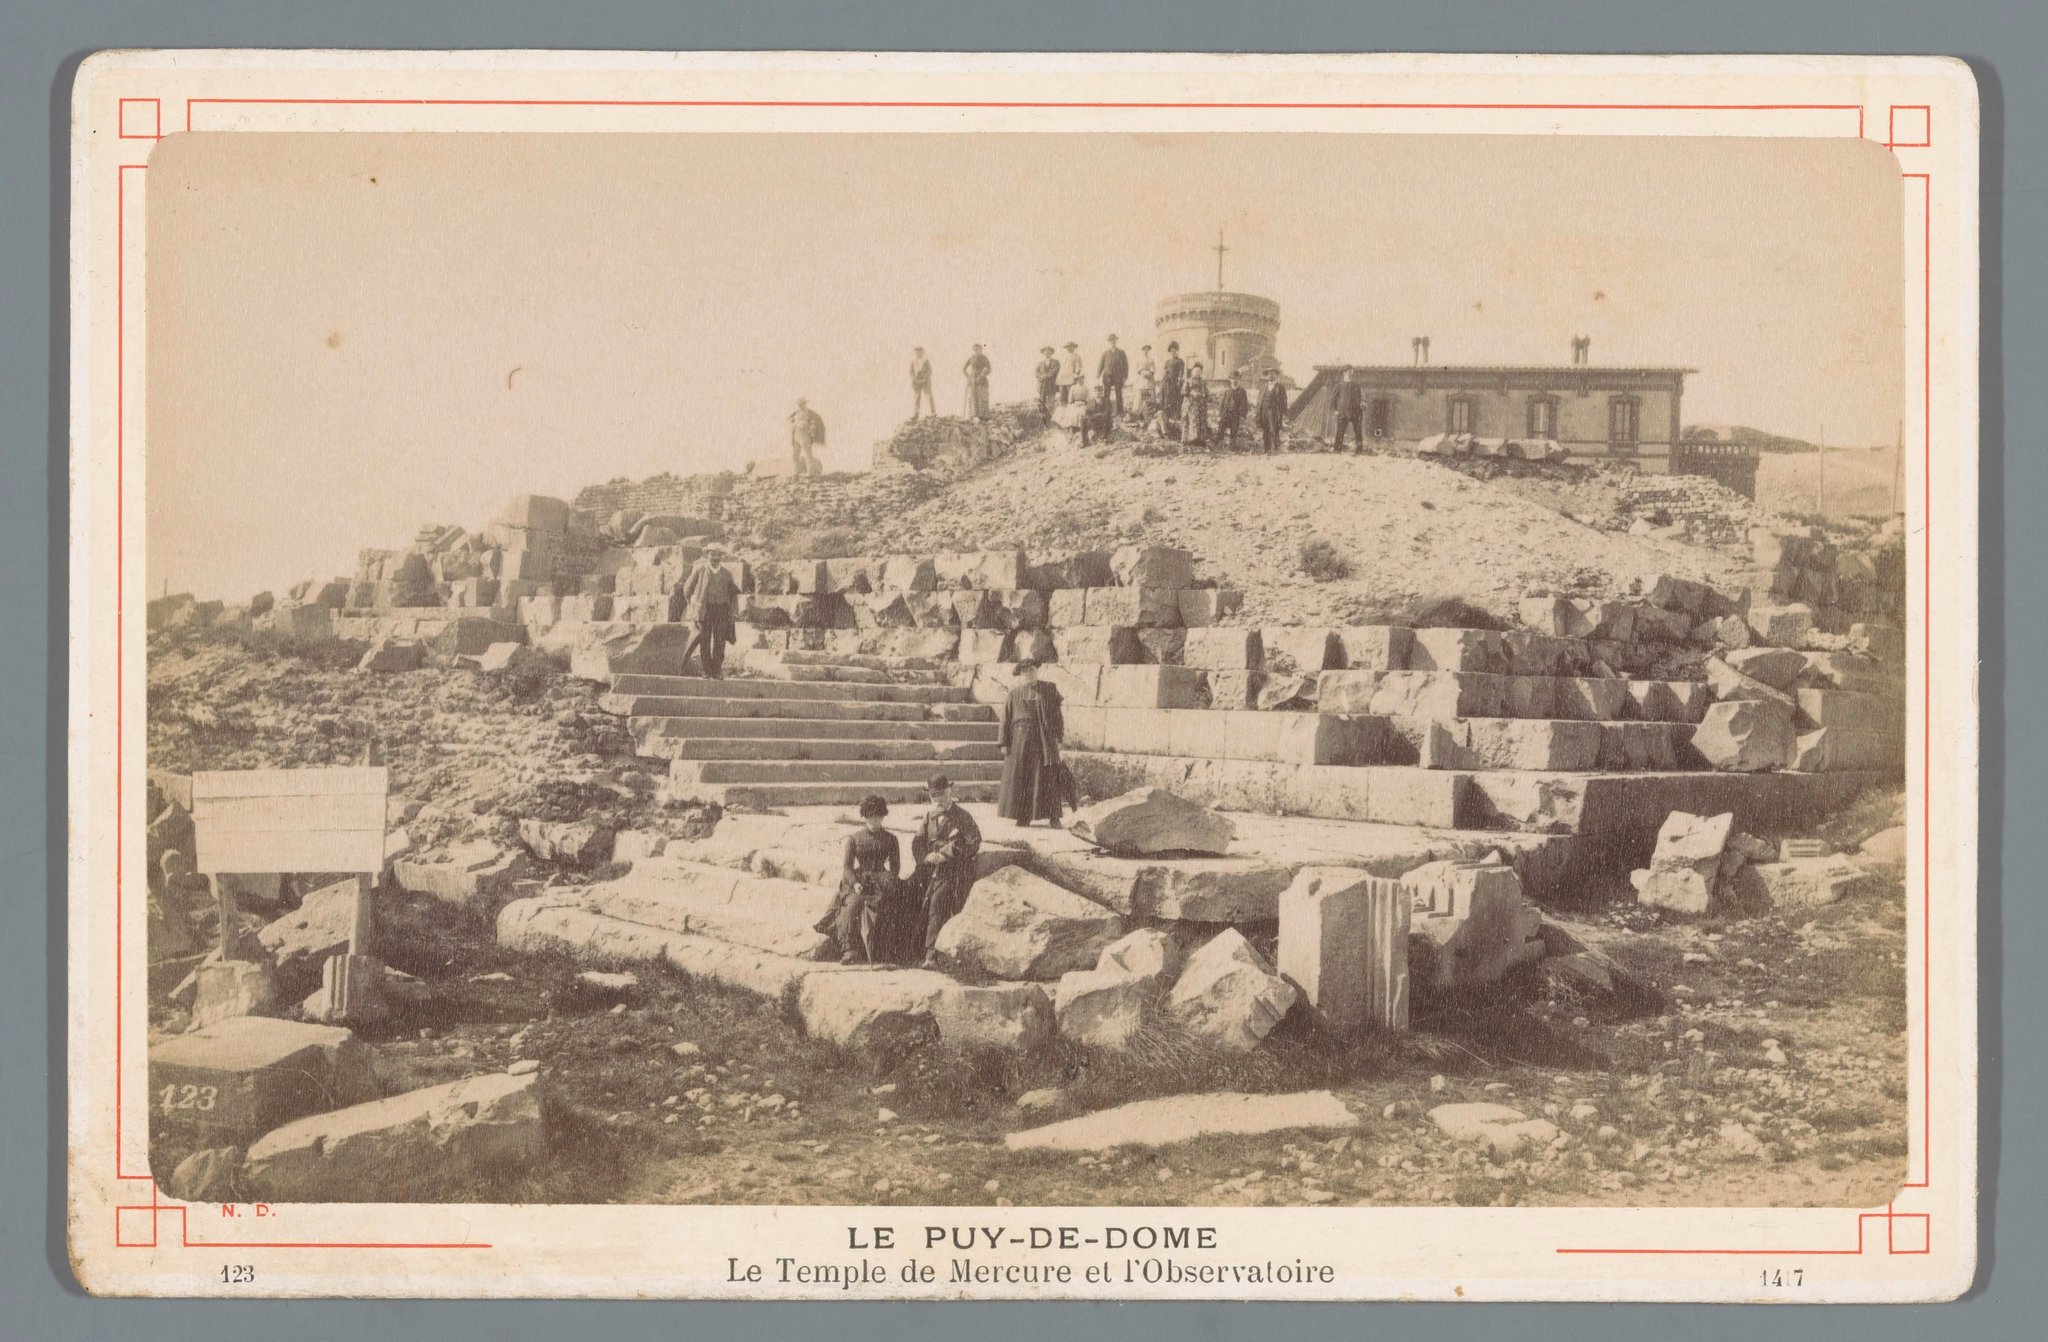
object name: cabinet photograph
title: Le Temple de Mercure et l'Observatoire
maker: étienne neurdein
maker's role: publisher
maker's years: 1832-1918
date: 1870-1900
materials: cardboard, photographic support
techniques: albumen print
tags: observatory (~ astronomy), landscape with ruins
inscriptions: number: ‘123’, initials: ‘N.D.’, number: ‘123/ 1417’